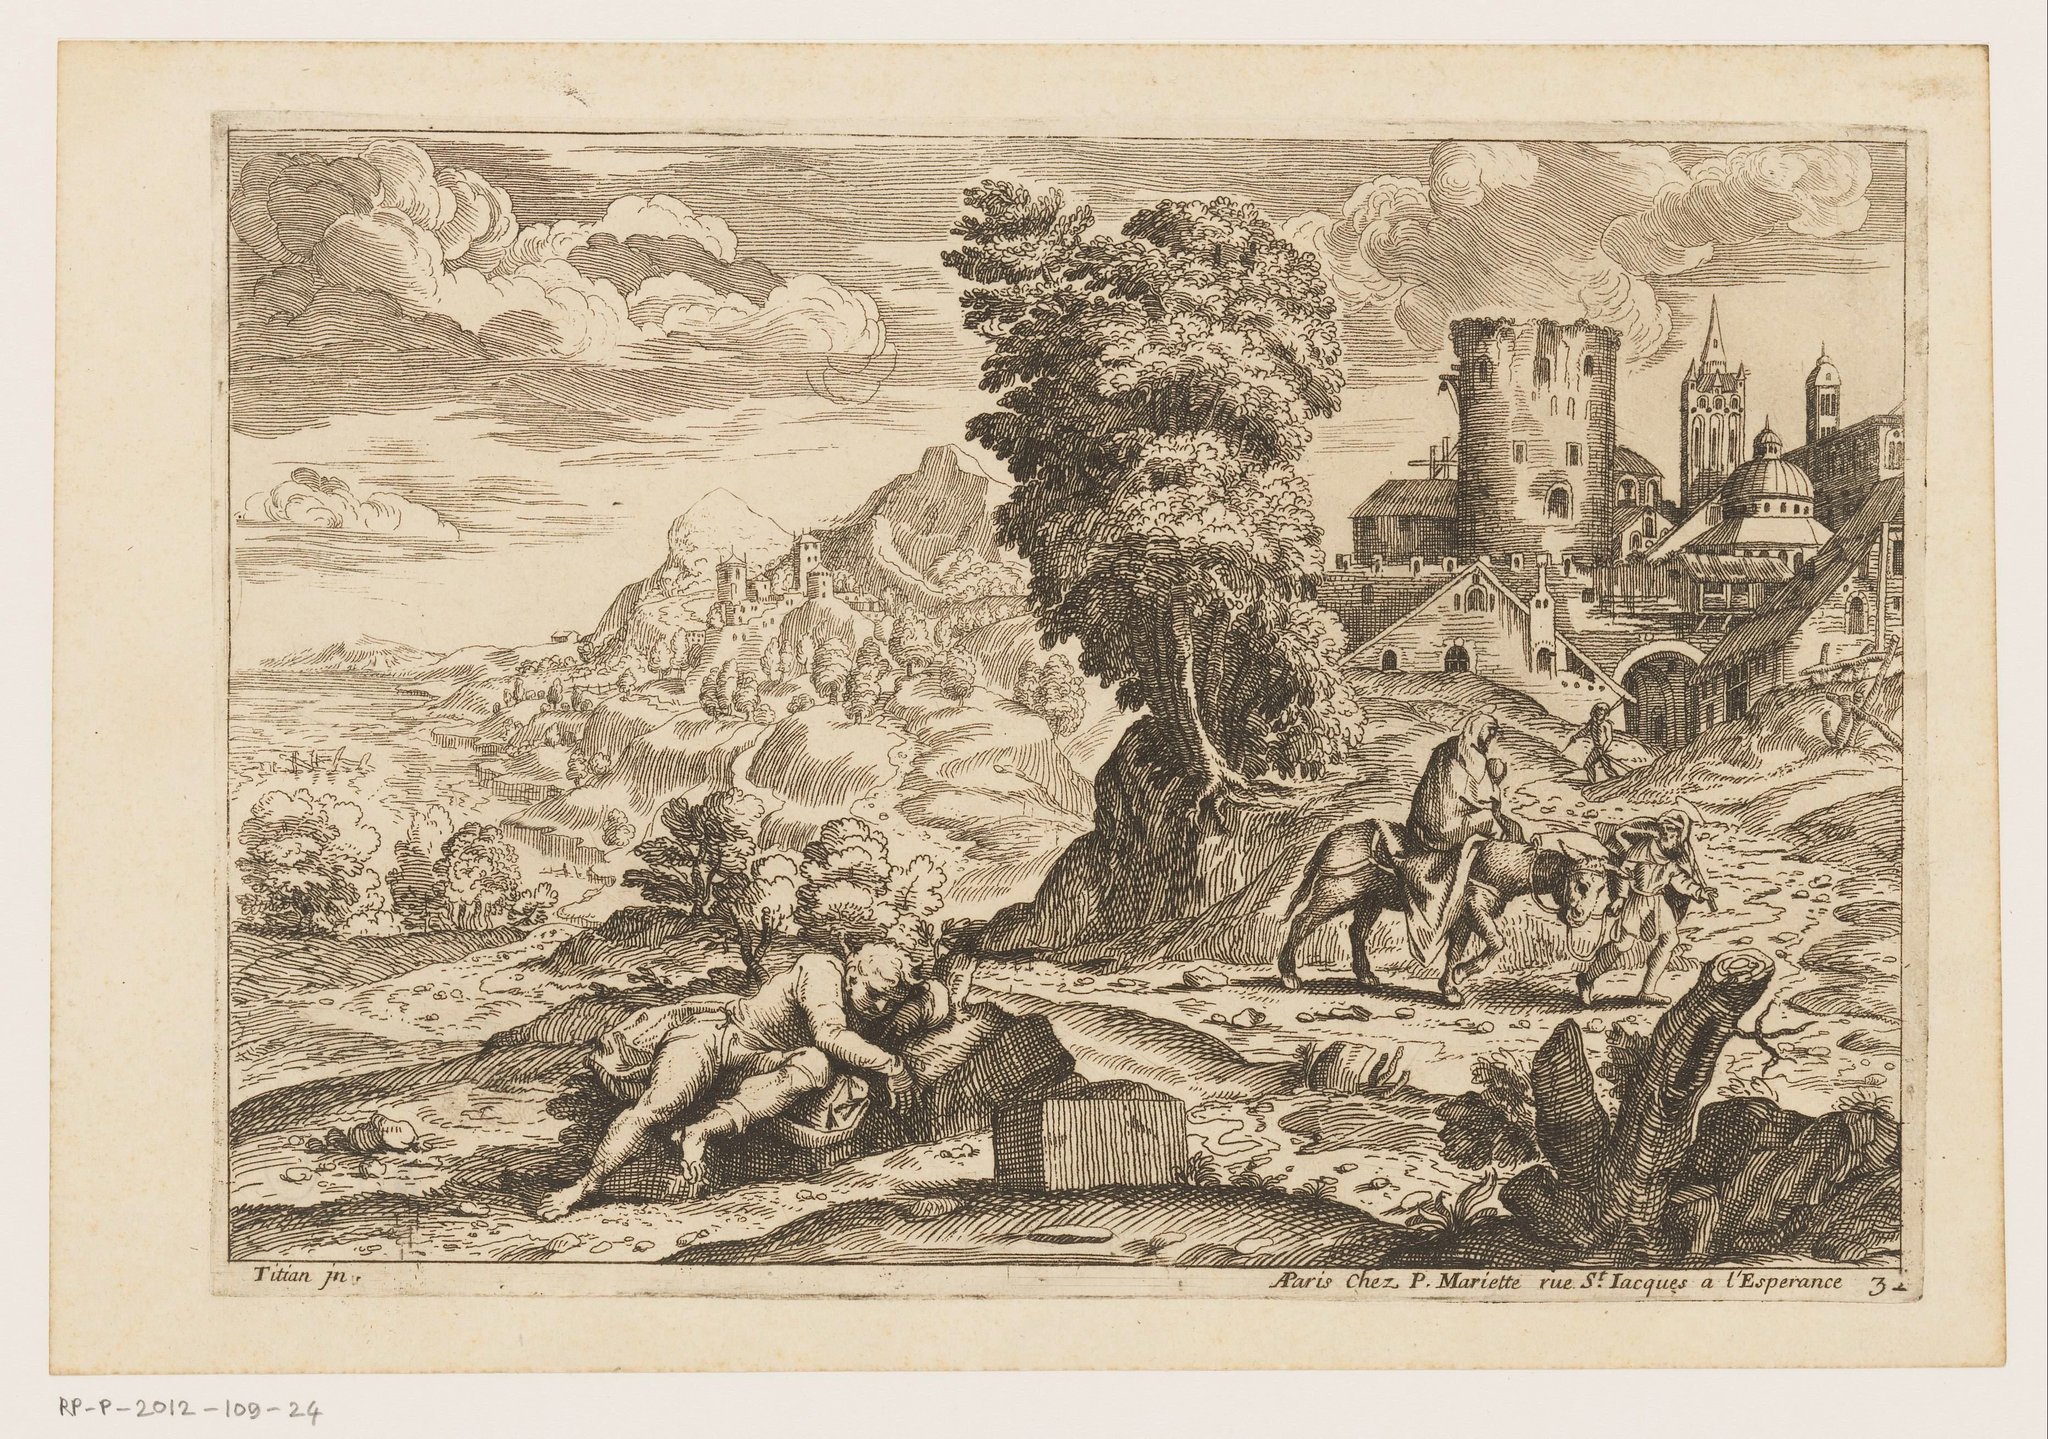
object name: print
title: Landschap met de vlucht naar Egypte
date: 1663-1726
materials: paper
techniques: etching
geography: paris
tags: the flight into egypt: mary, joseph, the child (and sometimes others) on their way; mary usually riding on an ass - bb - landscape predominant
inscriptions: collector's mark: Lugt 3473, collector's mark: Lugt 2228, collector's mark: Lugt 3474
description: Maakt deel uit van vierentwintigdelige serie met landschappen naar Titiaan en Campagnola.